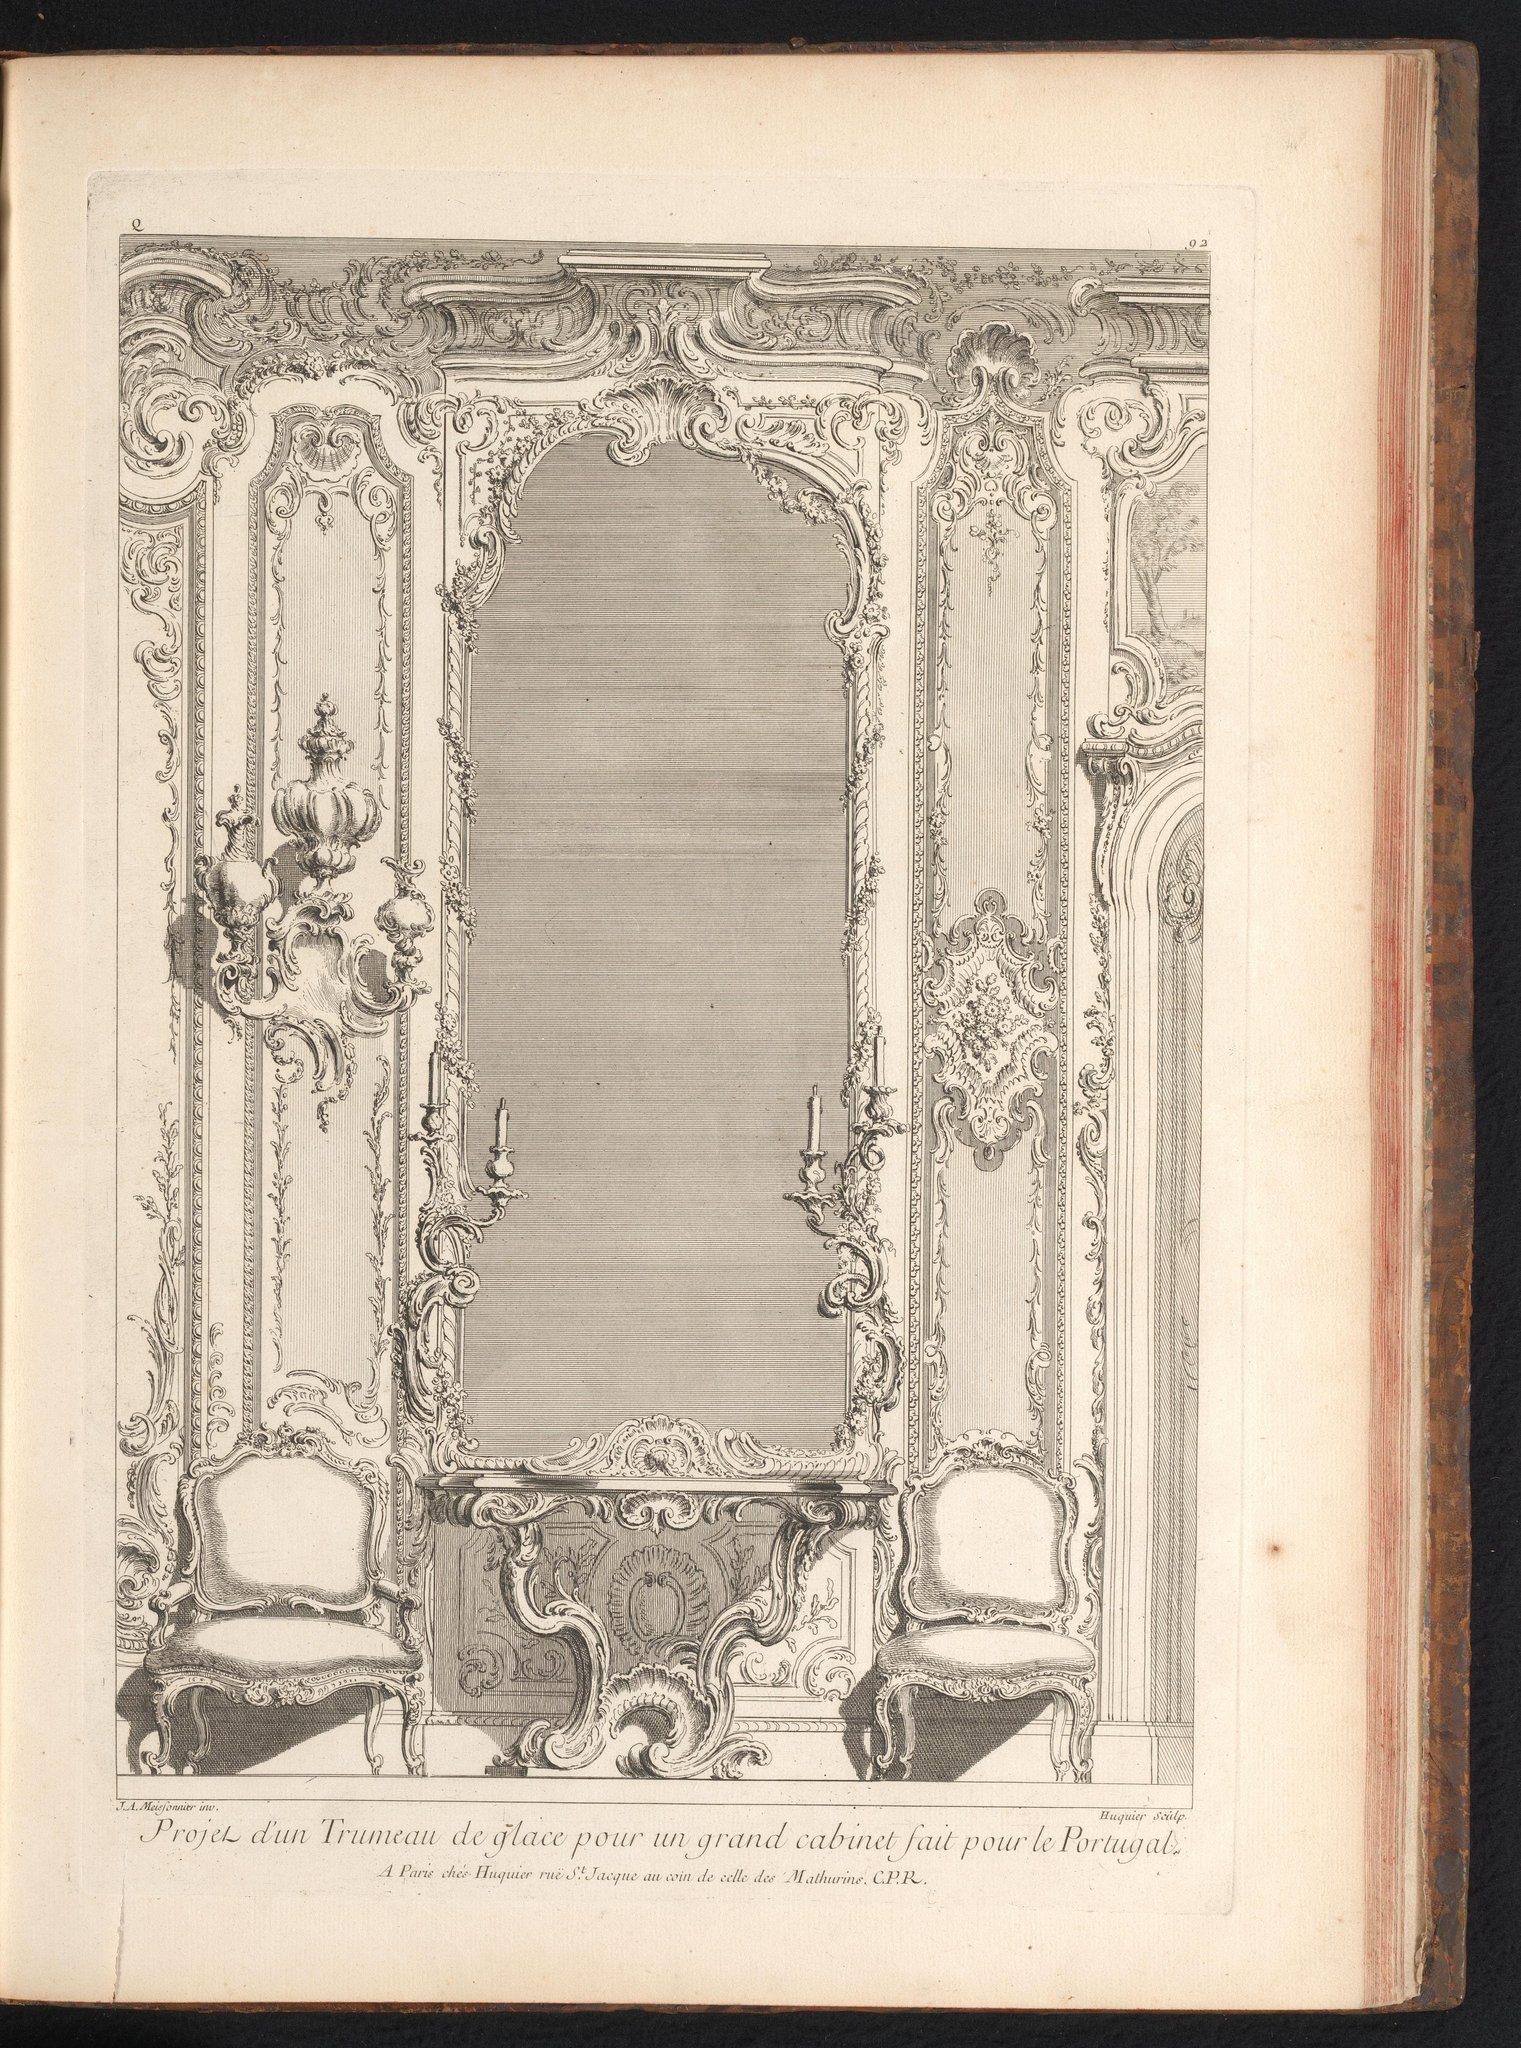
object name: ornament print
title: Oeuvre de Juste Aurele Meissonnier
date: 1738-1749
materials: paper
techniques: etching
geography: paris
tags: sconce, wall lamp, panelling, mirror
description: Deze prent maakt deel uit van een album.